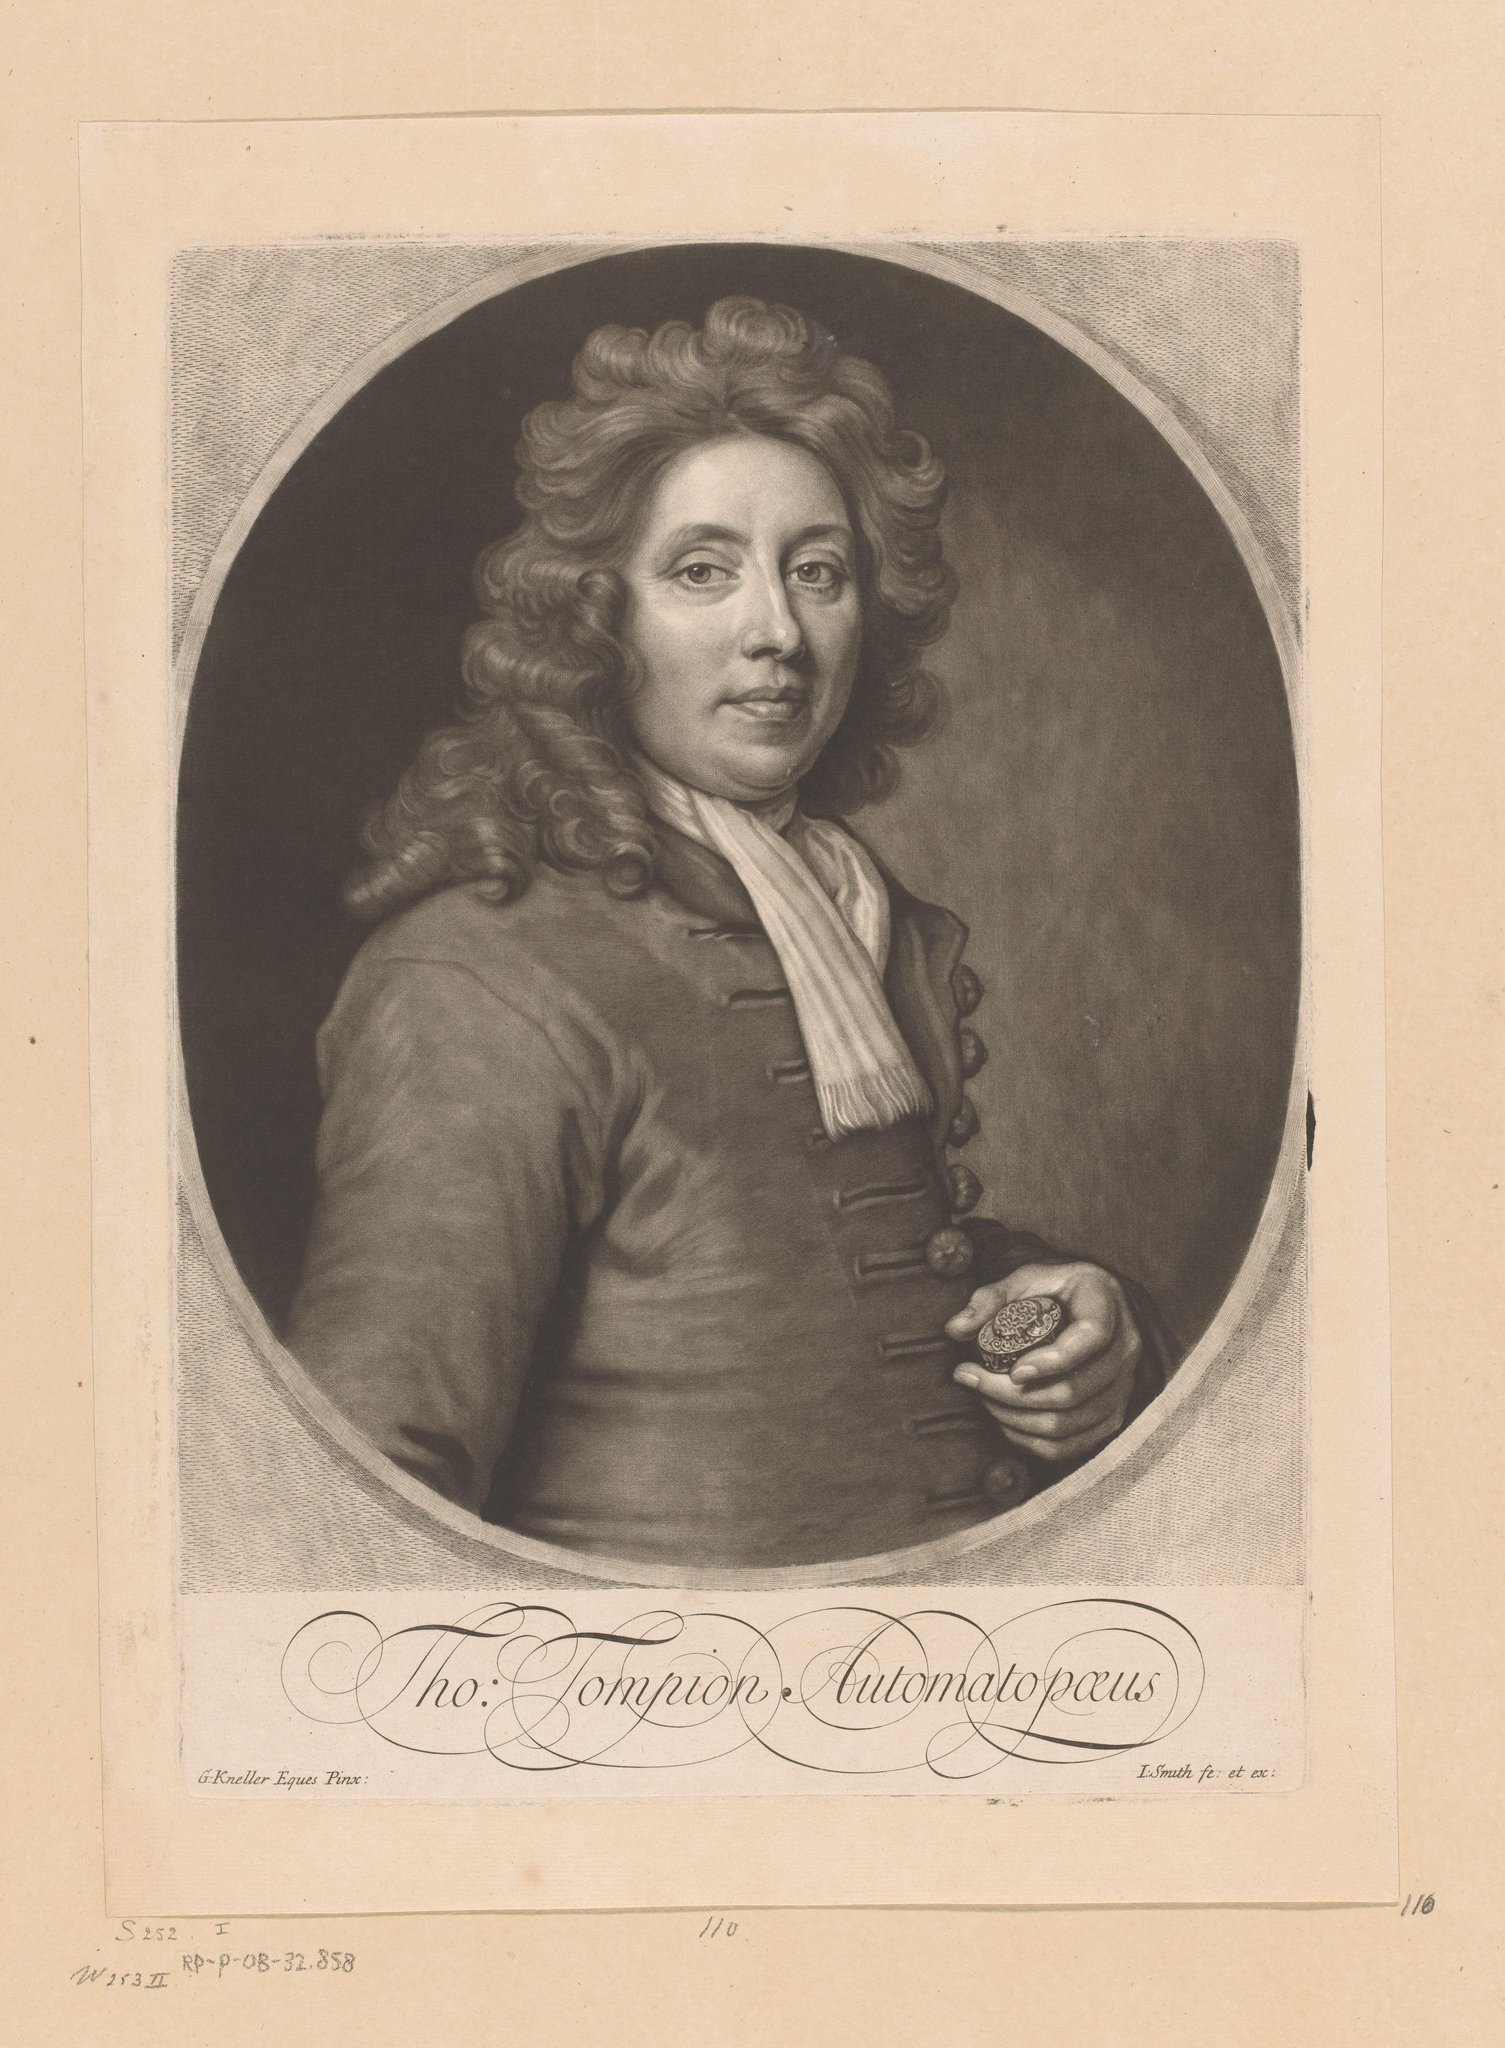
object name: print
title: Portret van Thomas Tompion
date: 1662-1742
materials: paper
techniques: mezzotint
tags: london, historical persons, watch, watchmaker, clockmaker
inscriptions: collector's mark: Lugt 240